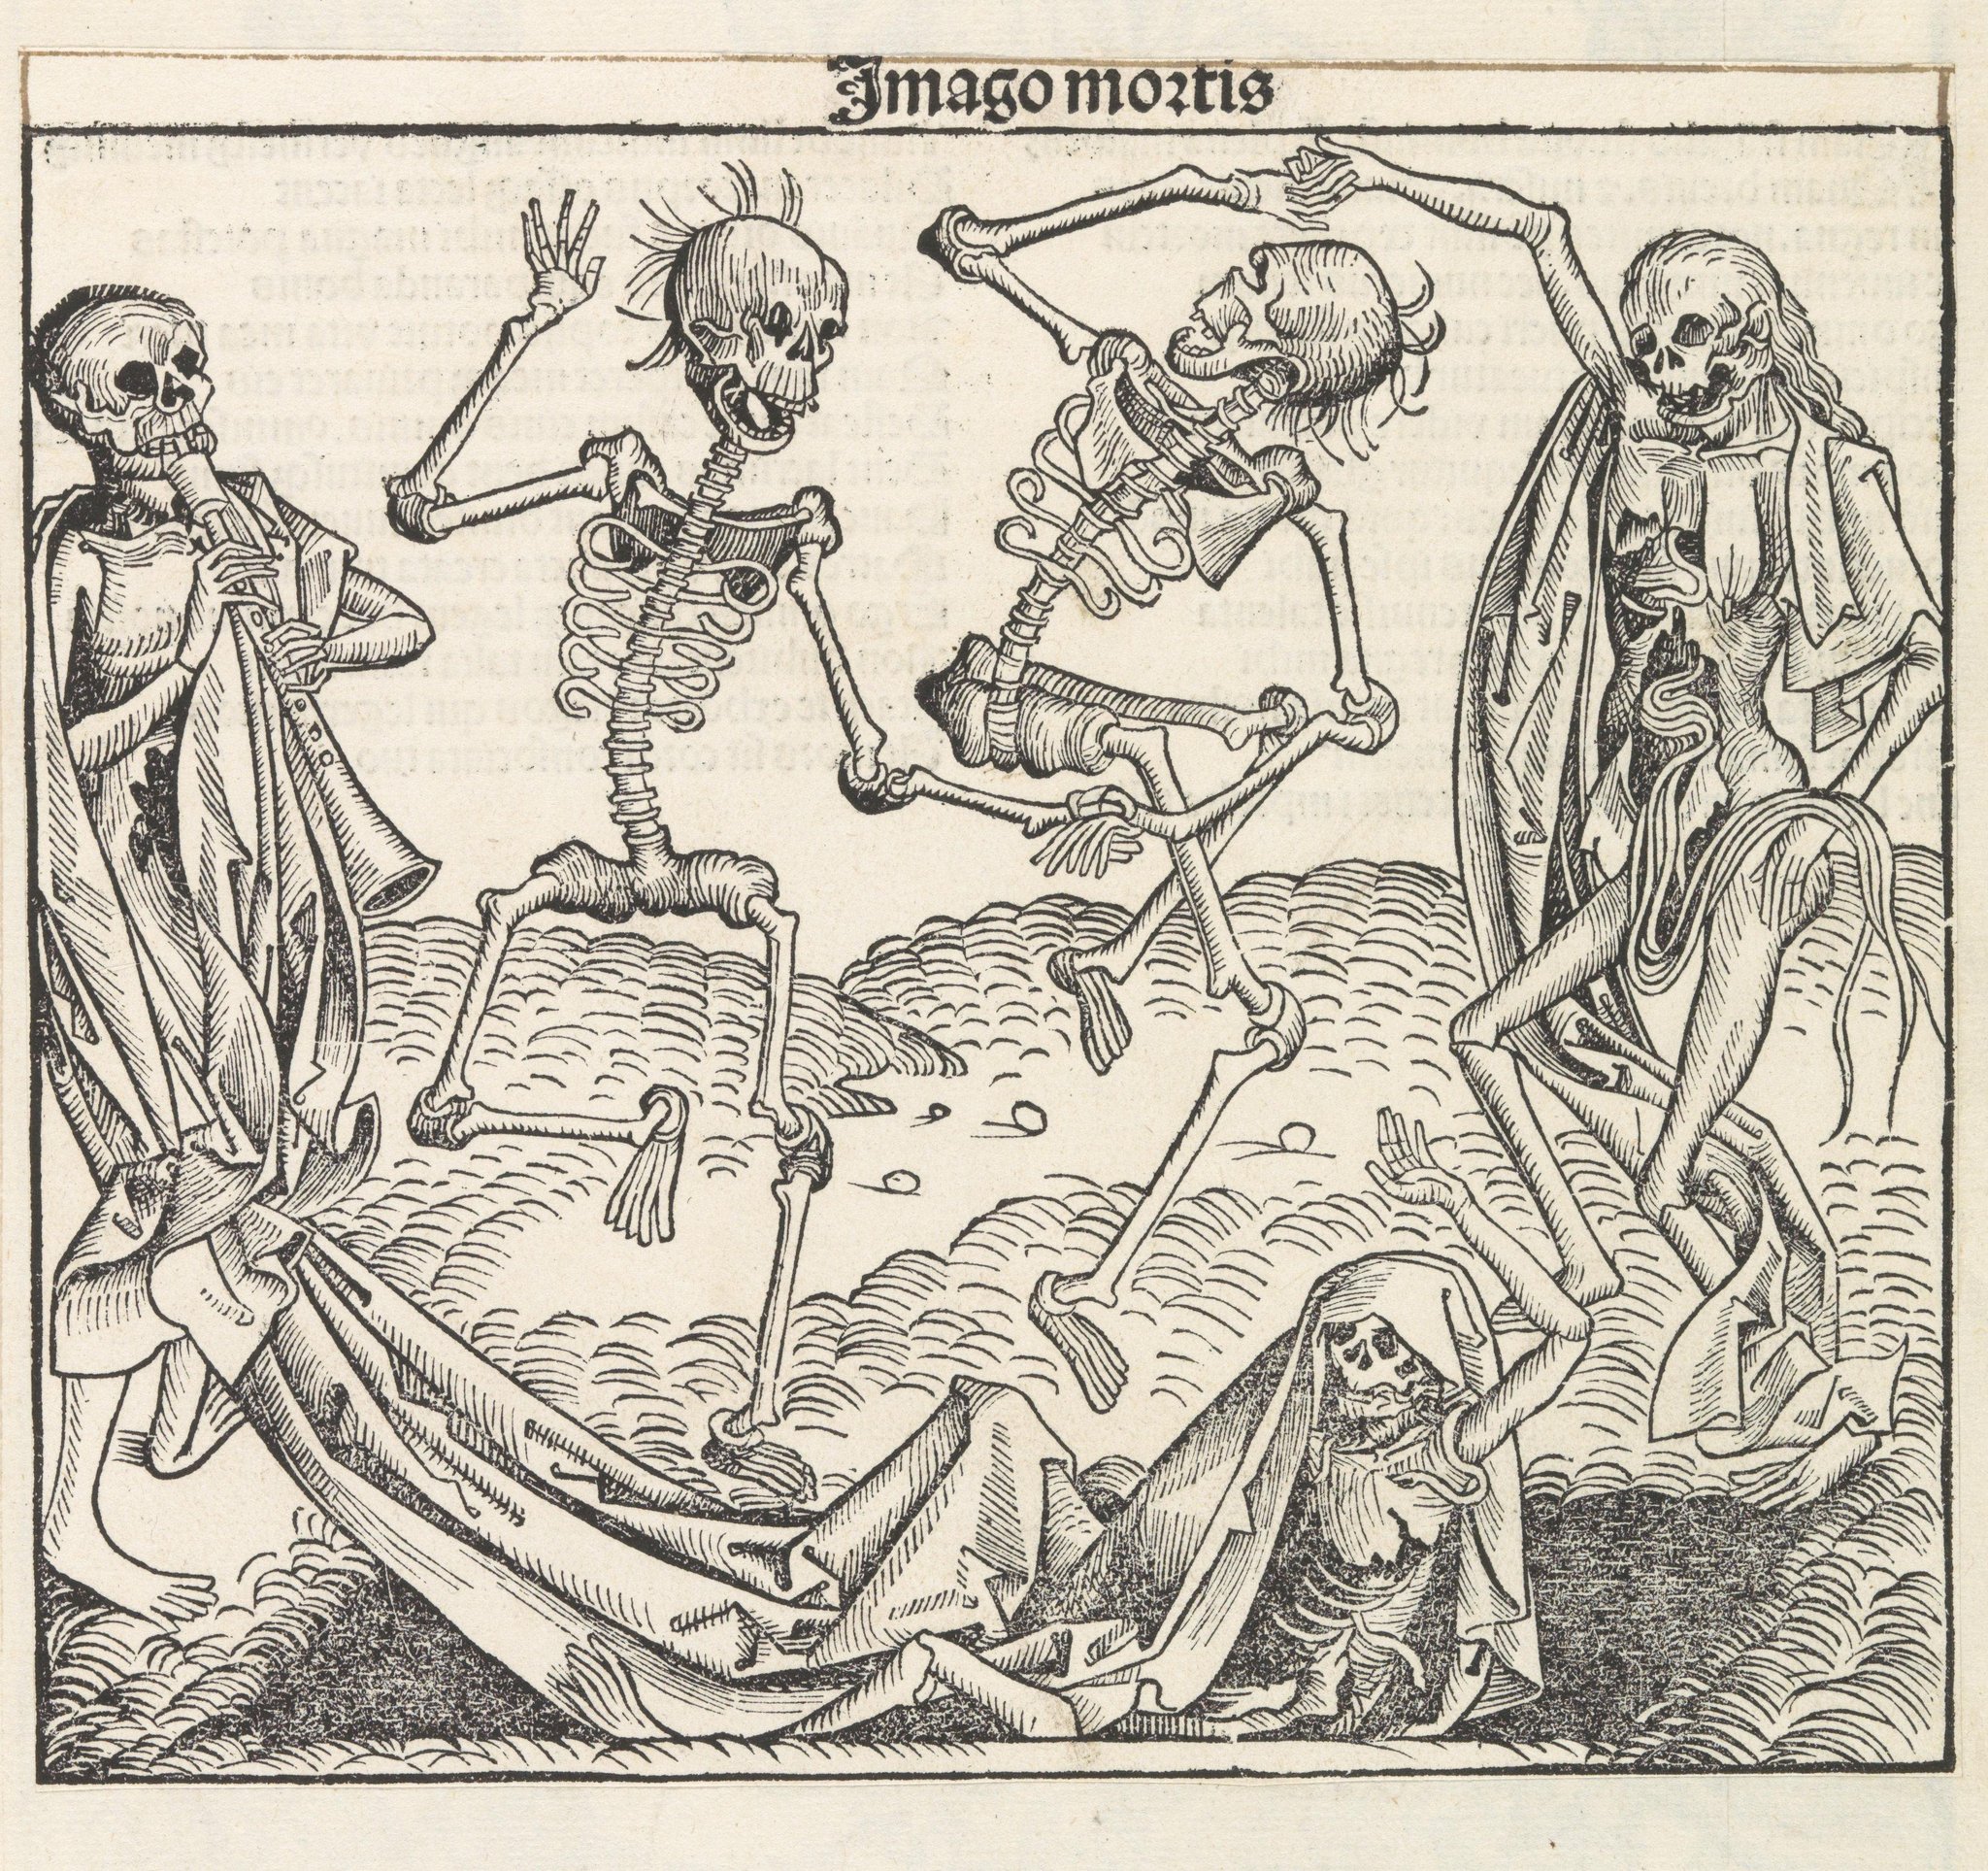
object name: book illustration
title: Dansende skeletten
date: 1493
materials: paper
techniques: letterpress printing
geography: nuremberg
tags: human life and its ages (young, adult, old, etc.), dance of death; death together with one or more human beings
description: De houtsnede wordt gebruikt als boekillustratie in de Liber Chronicarum (of Neurenbergkroniek) van Hartmann Schedel, verschenen in het Latijn en Duits in 1493. Zie de Latijnse uitgave, folio 264r.